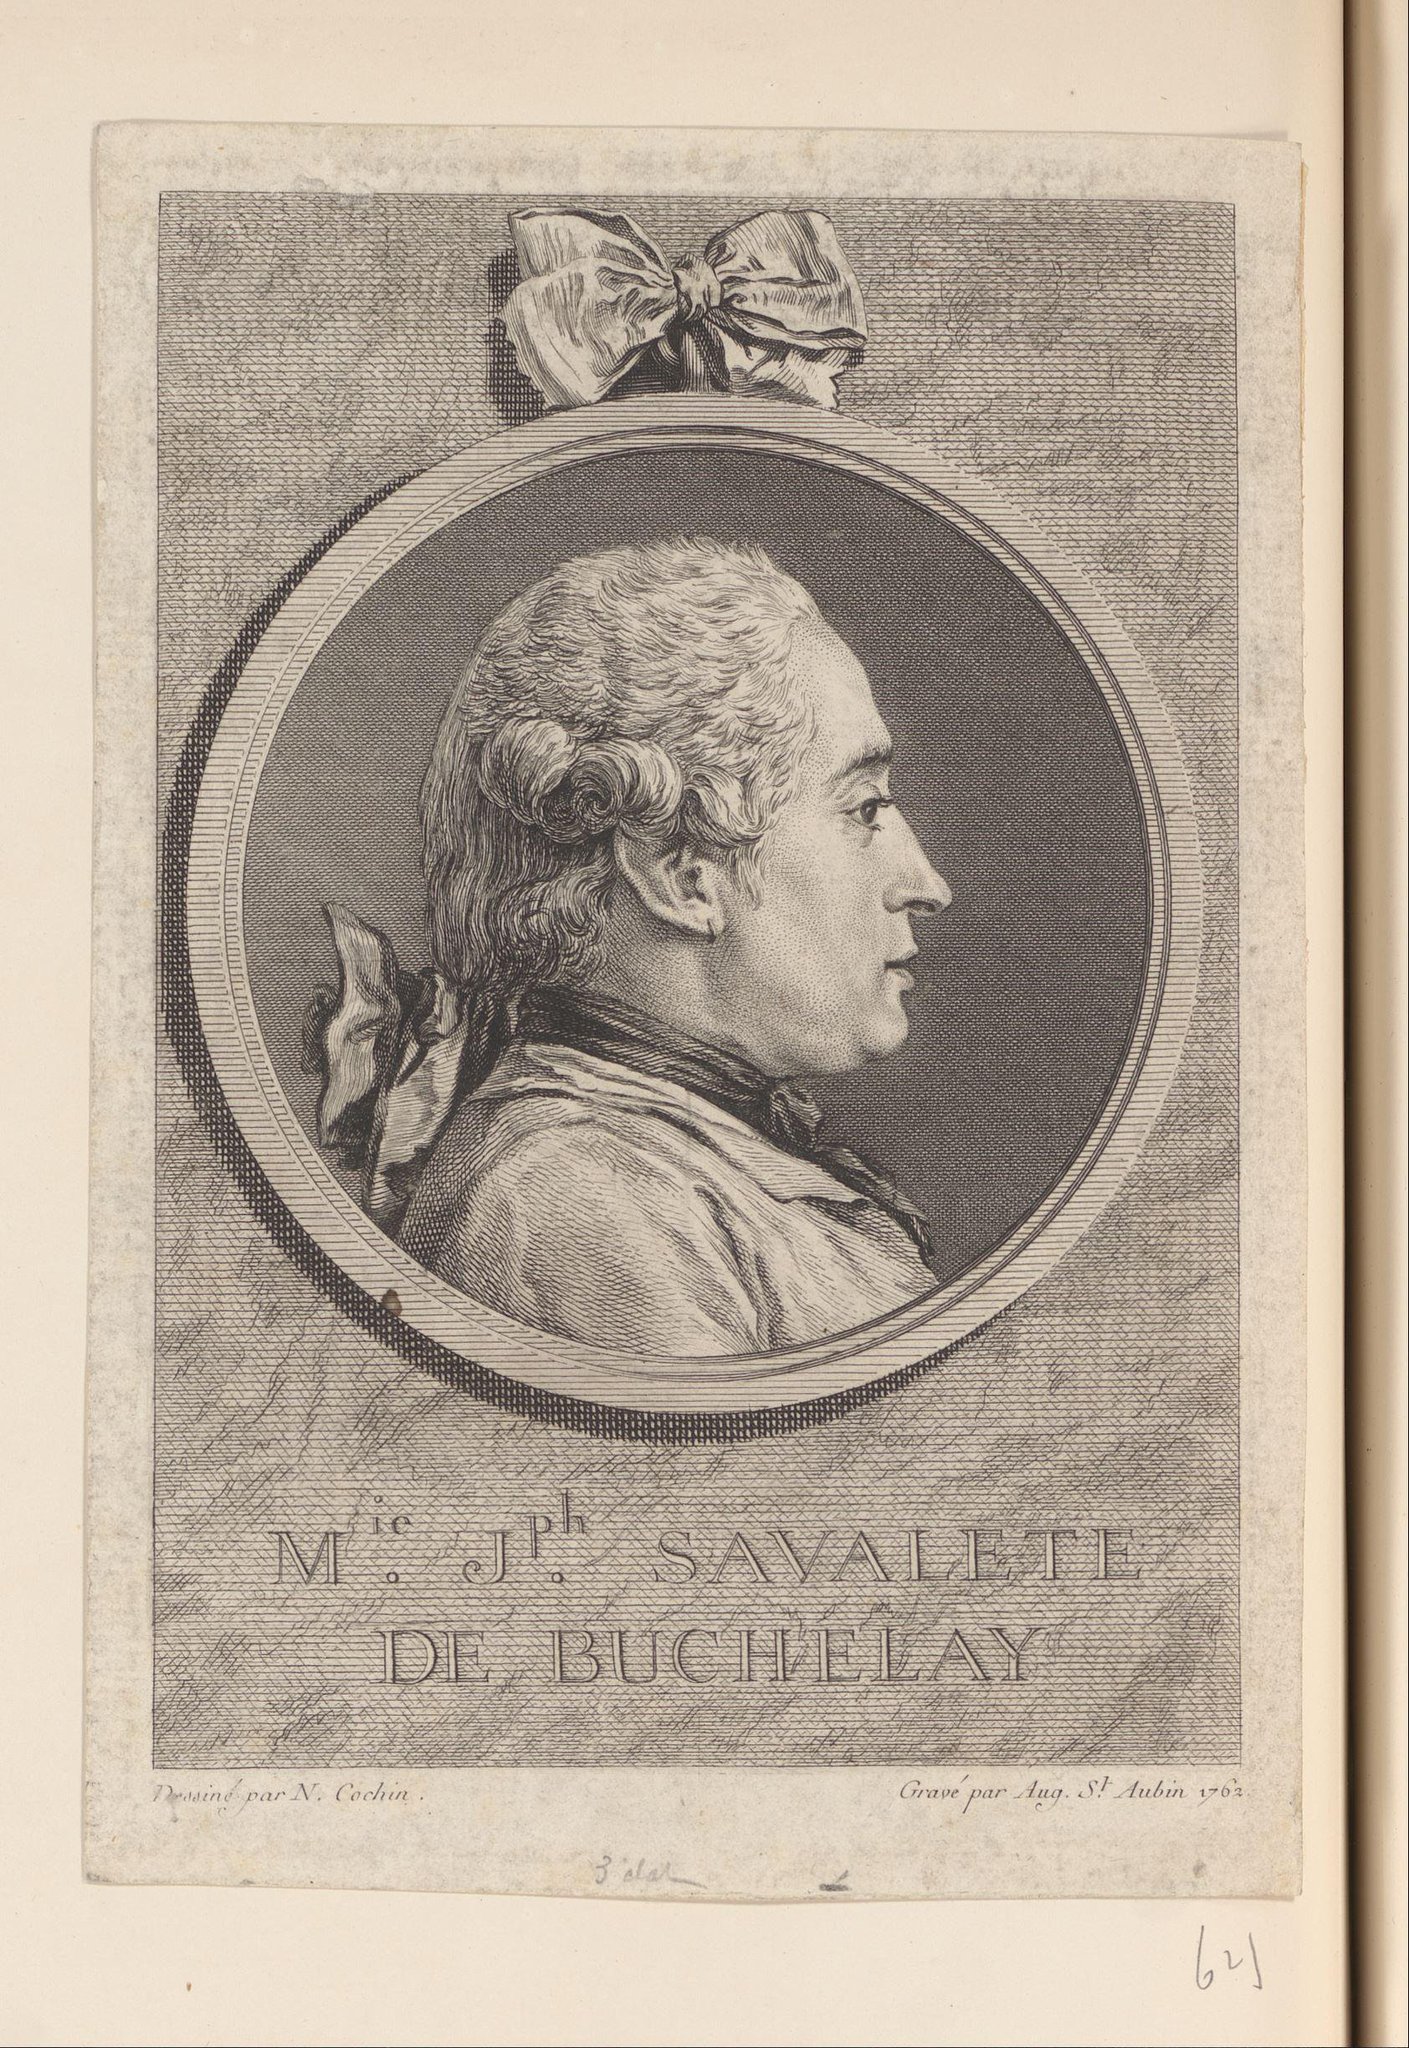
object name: album leaf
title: Portret van Marie-Joseph Savalette de Buchelay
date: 1762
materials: paper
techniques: engraving, etching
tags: historical persons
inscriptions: date